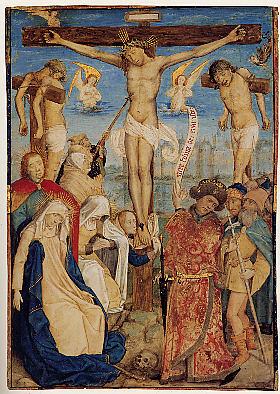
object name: leaf from a missal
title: The Crucifixion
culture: southern netherlandish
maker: monogrammist im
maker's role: artist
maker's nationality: southern netherlands, ghent (?)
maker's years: 1460-1490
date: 1480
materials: parchment, paint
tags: christ,virgin mary,crucifixion